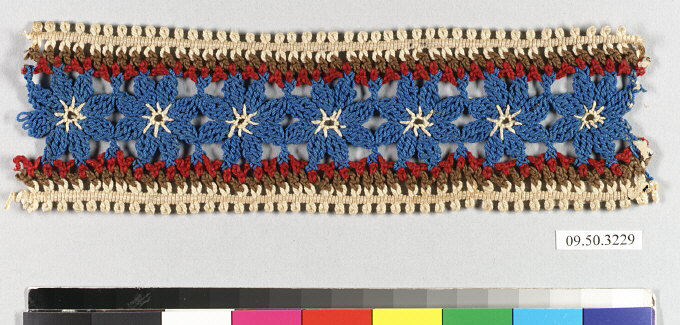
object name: sample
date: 1801-1900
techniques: crochet